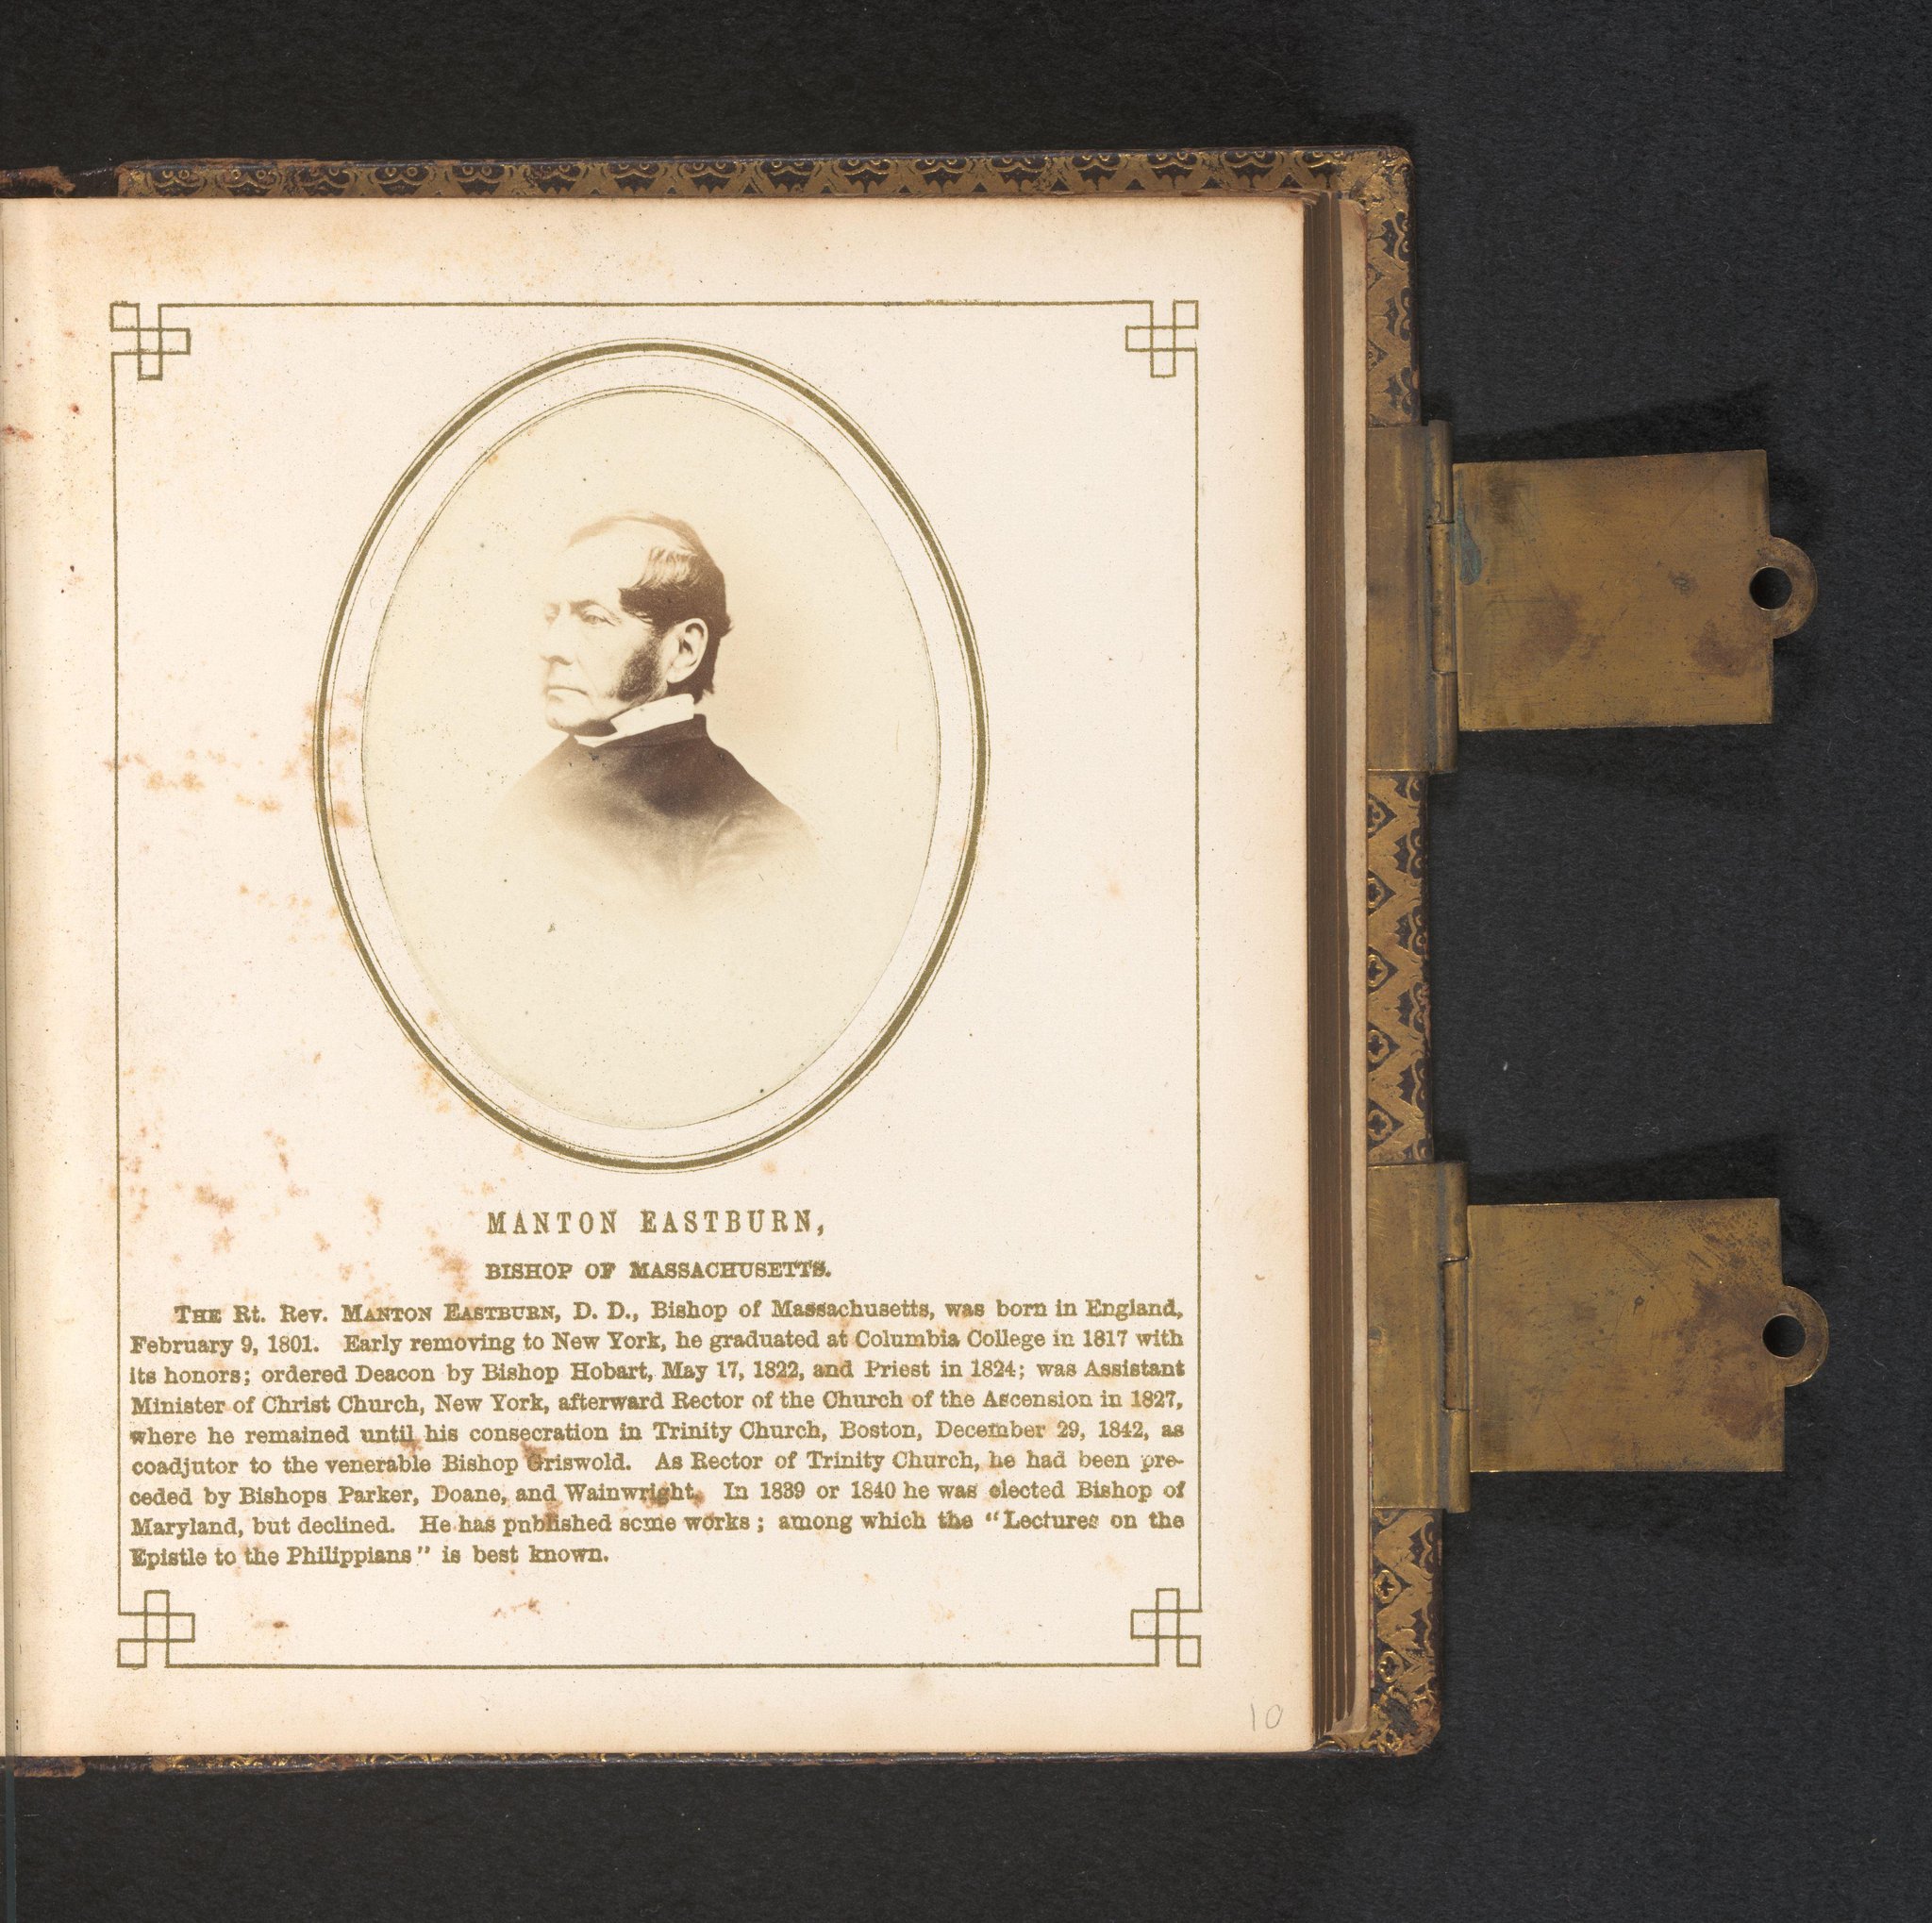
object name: page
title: Portret van Manton Eastburn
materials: photographic support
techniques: albumen print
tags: historical persons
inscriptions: inscription: ‘Manton Eastburn/ Bishop of Massachusetts/ (...)’